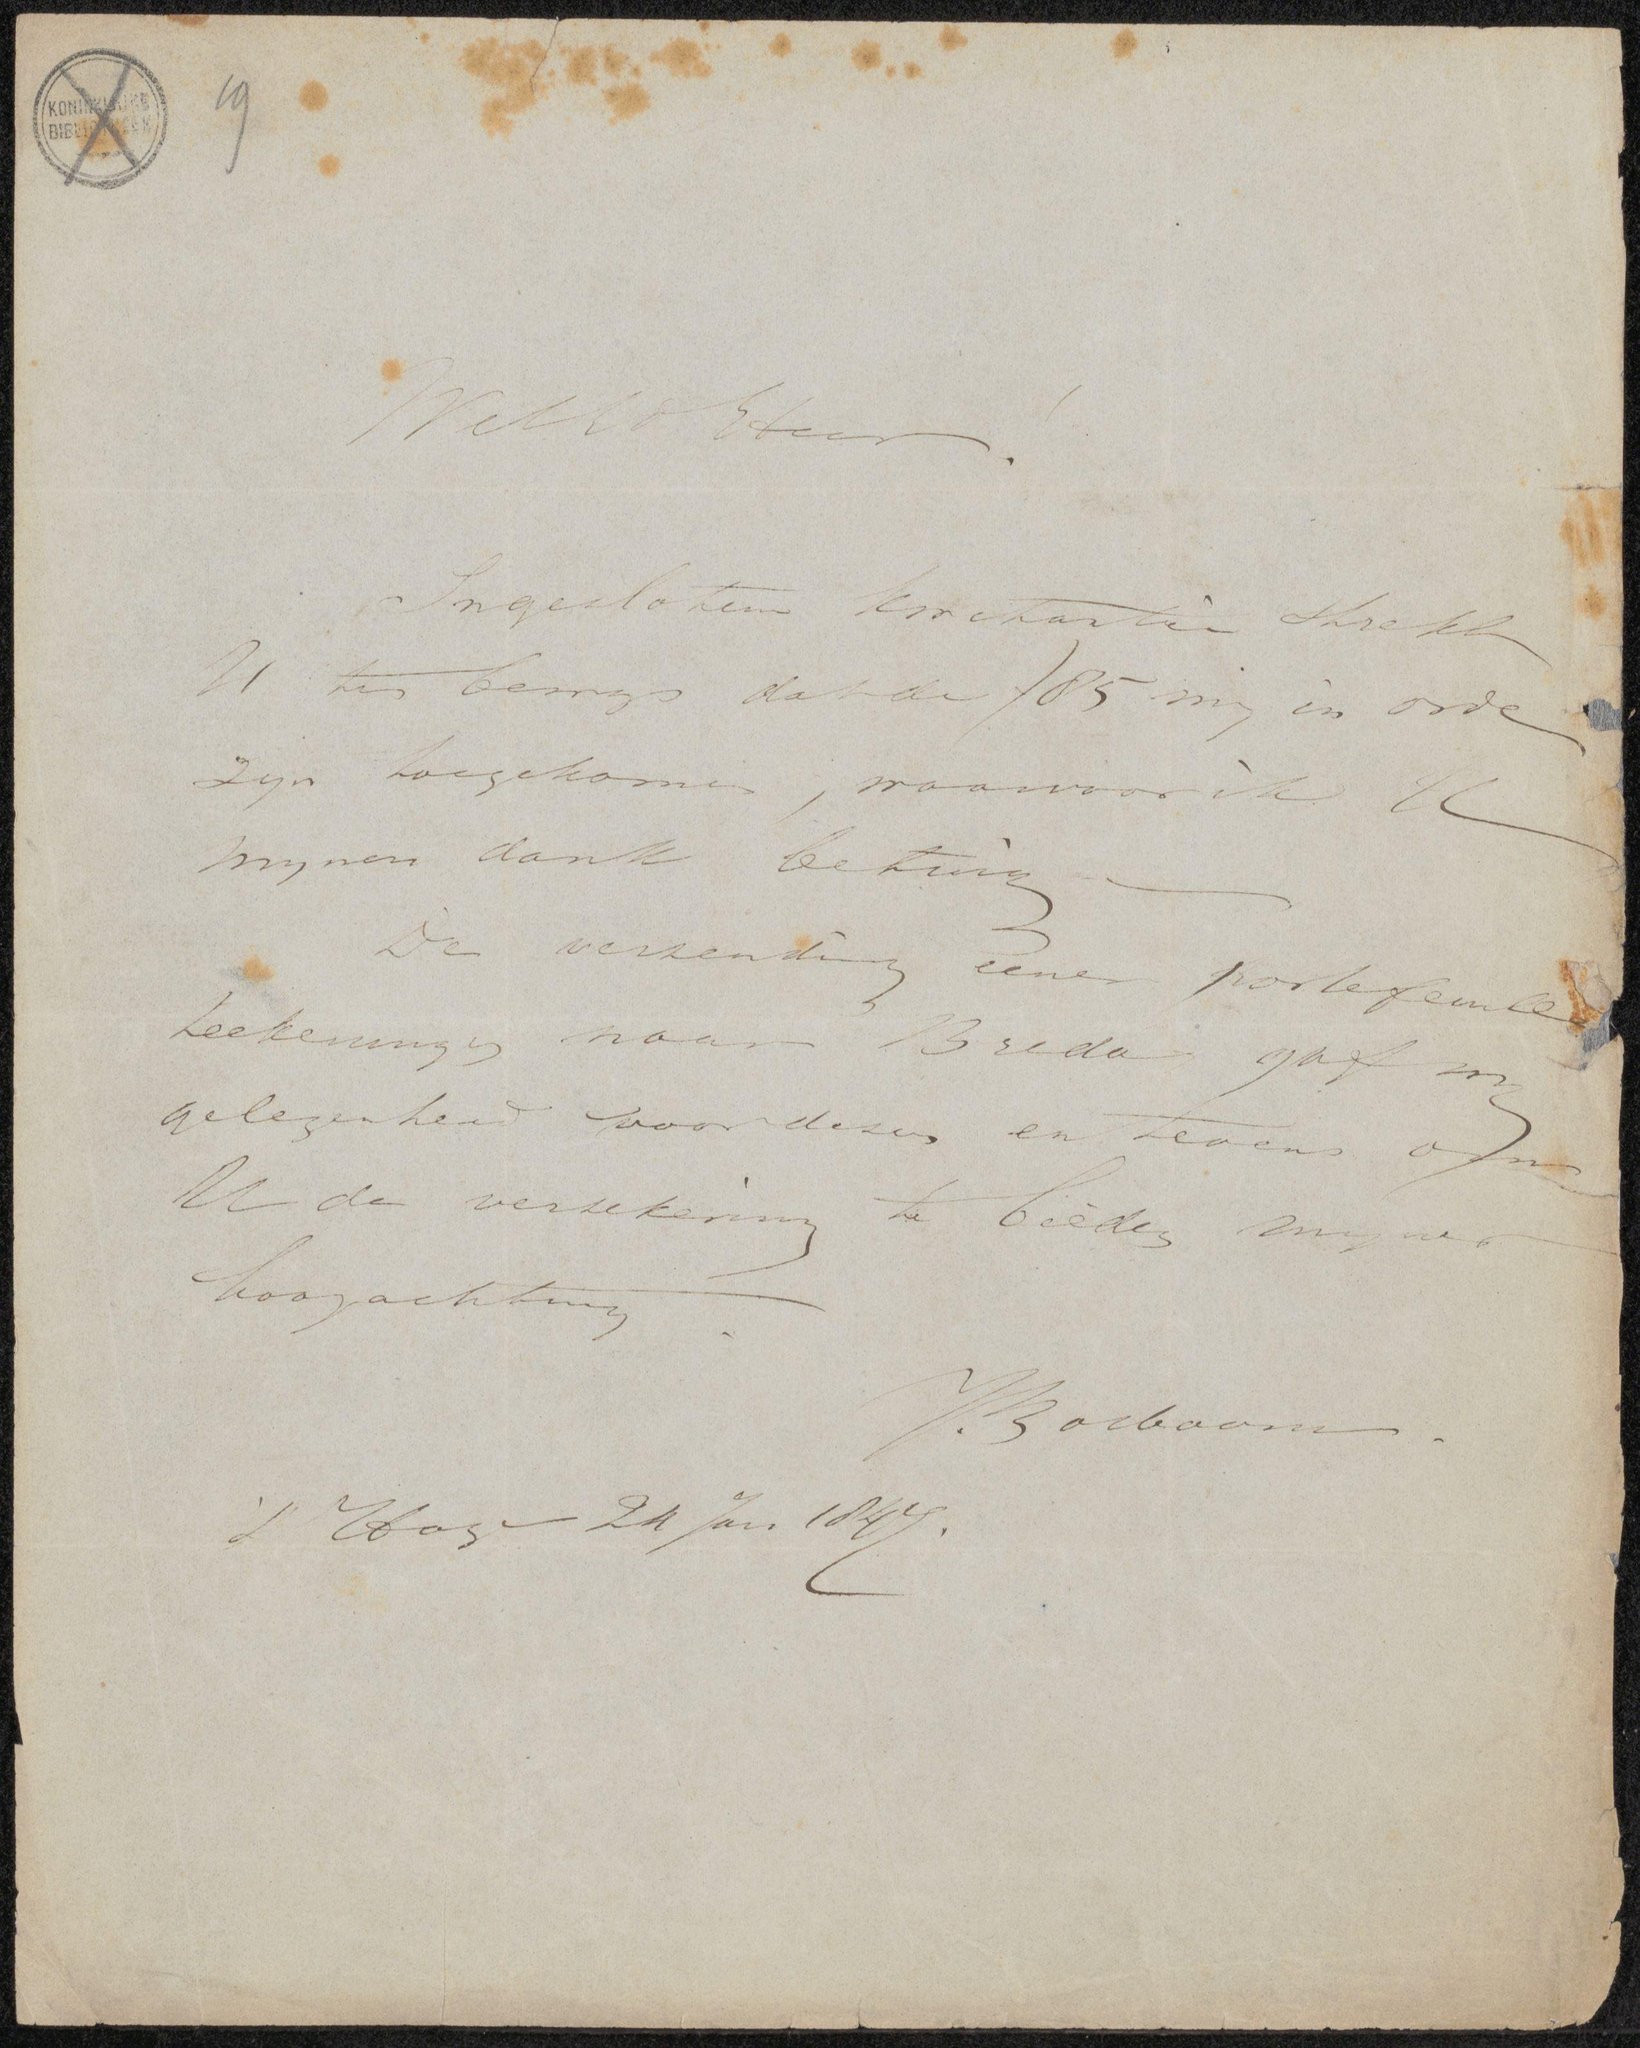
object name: letter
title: Brief aan C.J. de Lang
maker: johannes bosboom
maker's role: draughtsman, painter, print maker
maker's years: 1817-1891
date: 1847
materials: ink, paper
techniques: pen, writing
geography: the hague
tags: drawing, money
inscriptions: collector's mark: ‘KONINKLIJKE BIBLIOTHEEK’, collector's mark: Lugt 2233